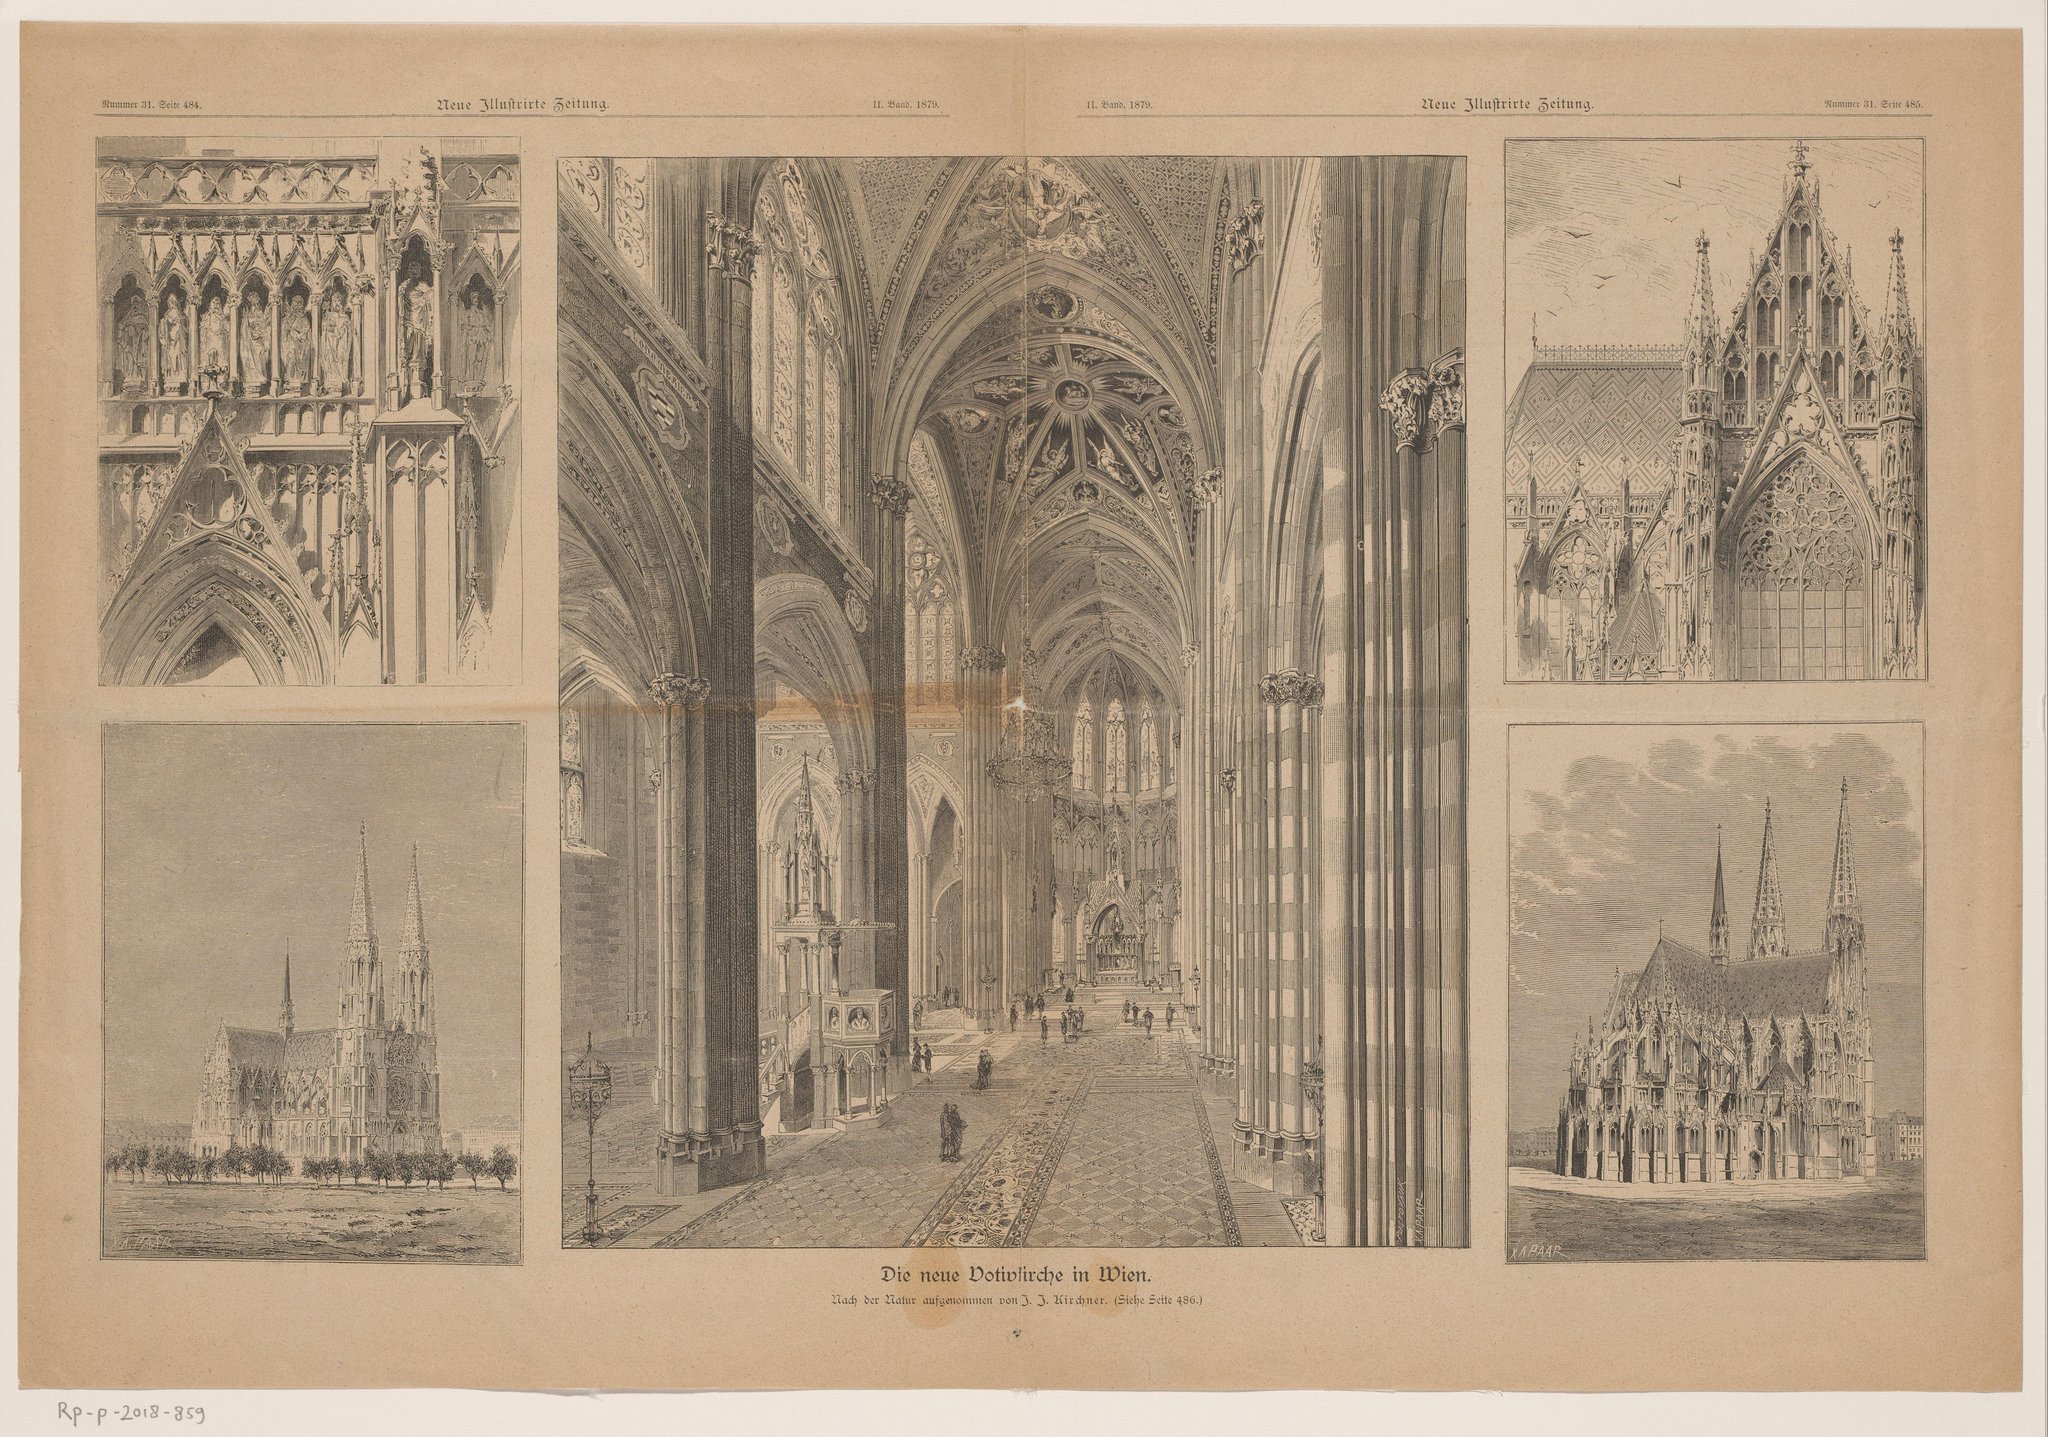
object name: print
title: Gezichten op de binnen- en buitenkant van de Votiefkerk te Wenen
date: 1879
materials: paper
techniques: letterpress printing, engraving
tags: church (exterior), interior of church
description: Gezichten op de binnen- en buitenkant van de Votiefkerk te Wenen. Met Duitse tekst in boekdruk op verso.